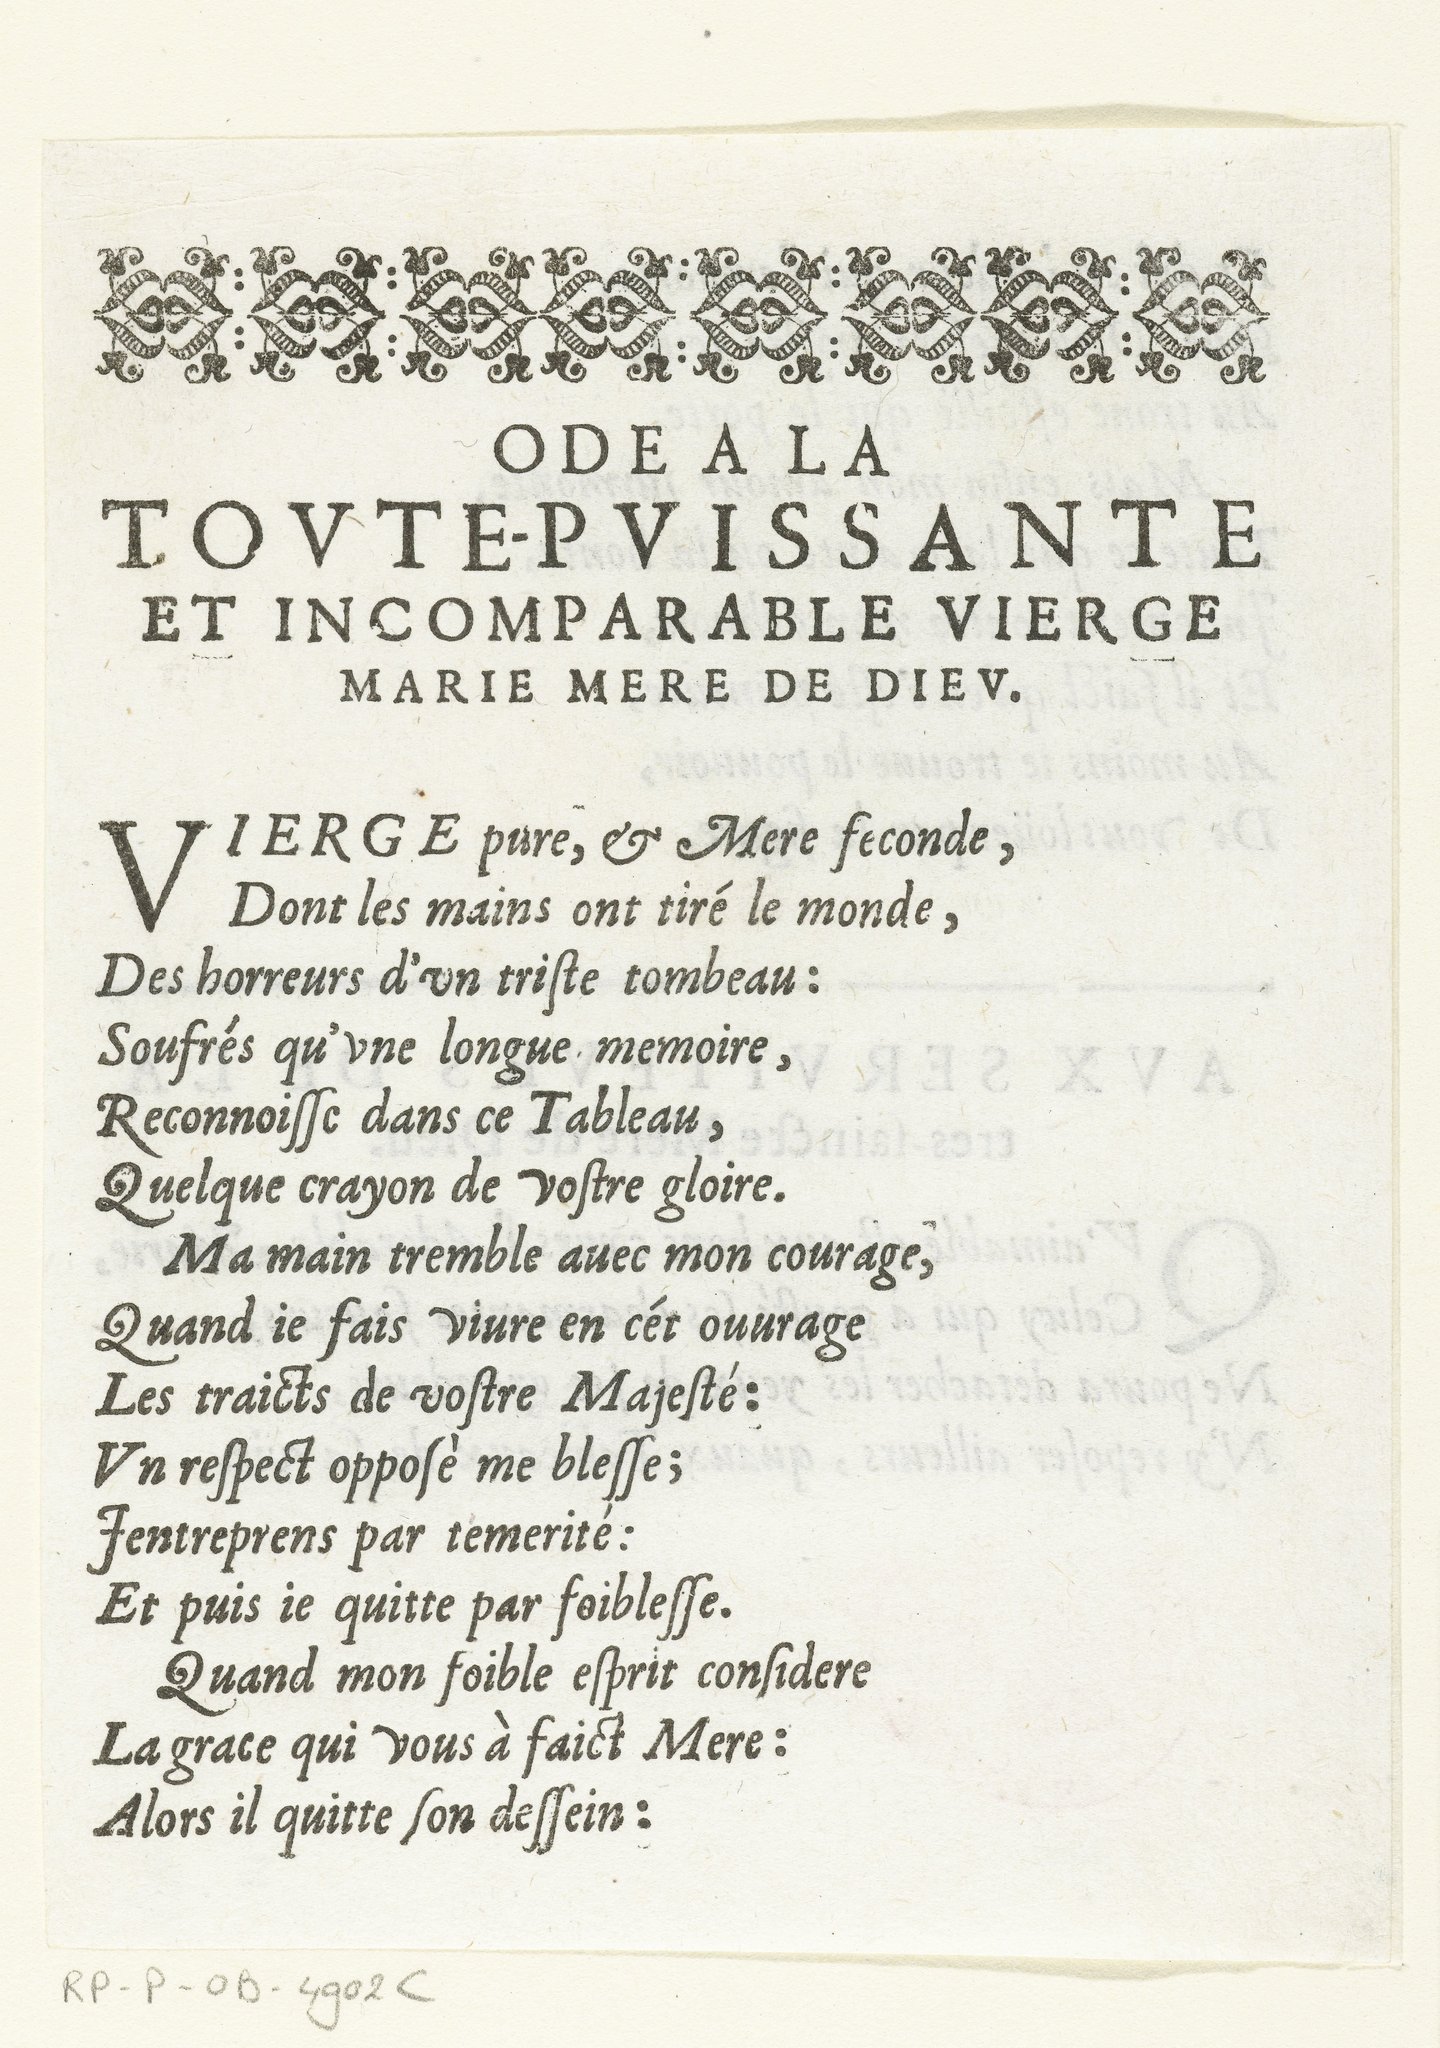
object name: text sheet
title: Leven van Maria in emblemen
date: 1625-1629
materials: paper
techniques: letterpress printing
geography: france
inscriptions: collector's mark: Lugt 240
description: Een lovende tekst, gericht aan Maria, gesteld in Franse verzen. Dit blad (aan beide zijden bedrukt) is onderdeel van de eerste staat van de embleemserie 'Leven van Maria in emblemen', die naast een titelpagina en deze lofzang nog twee lofzangen en 26 emblemen behelst.